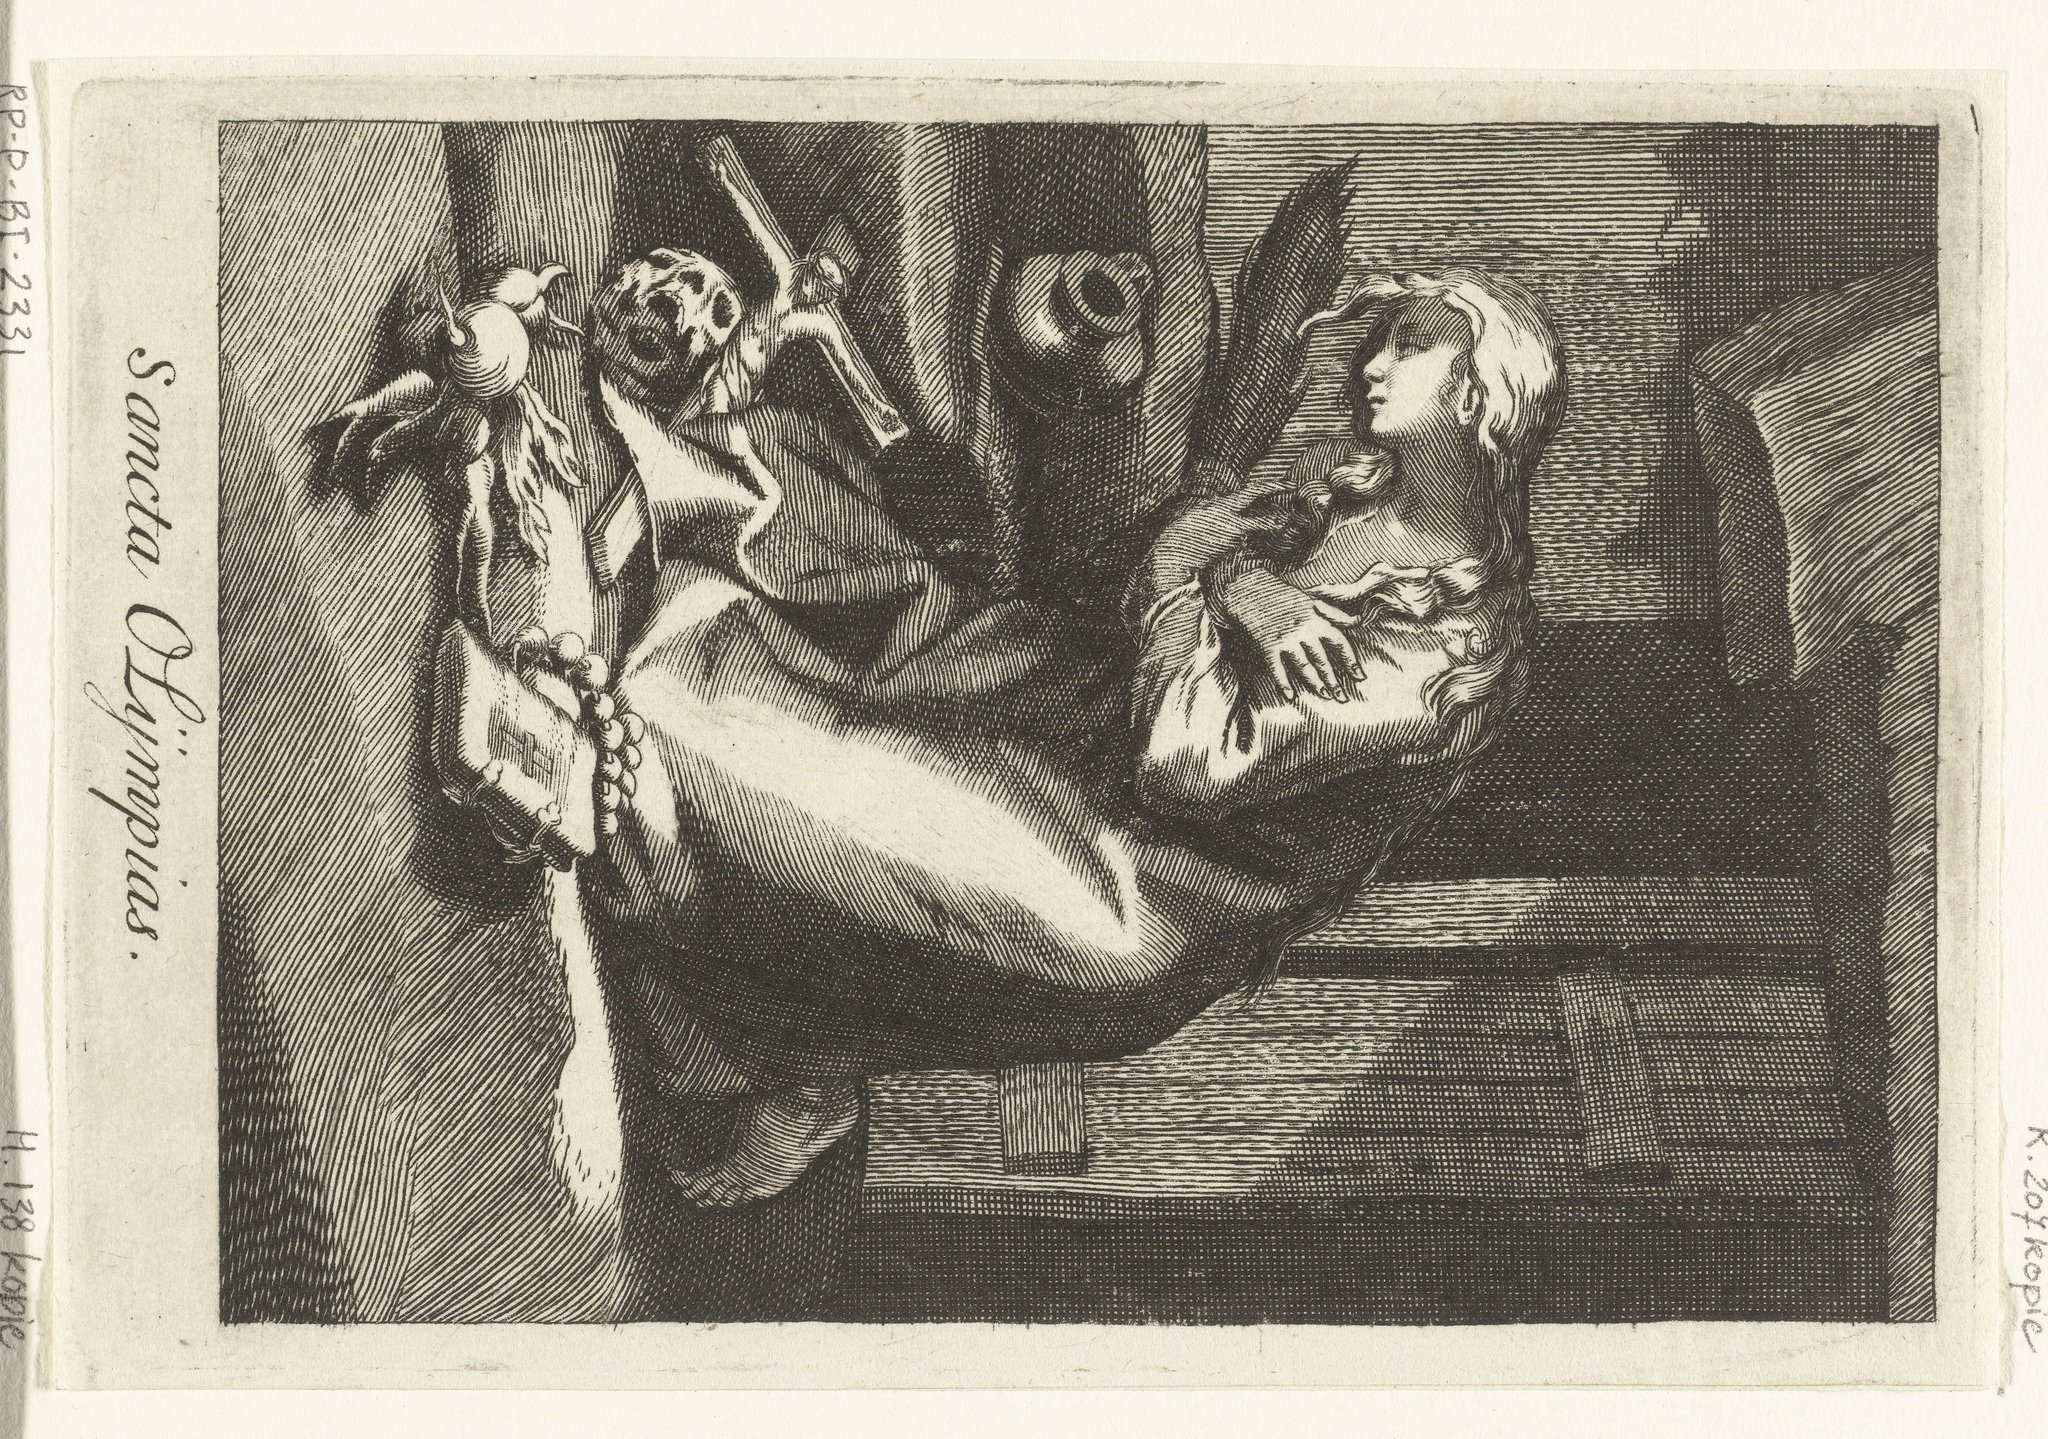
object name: print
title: Kluizenaressen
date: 1590-1662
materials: paper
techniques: engraving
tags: anchorite, hermit, female saints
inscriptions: collector's mark: Lugt 2228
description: Kopie in spiegelbeeld naar prent van Boëtius Adamsz. Bolswert uit serie Kluizenaressen.